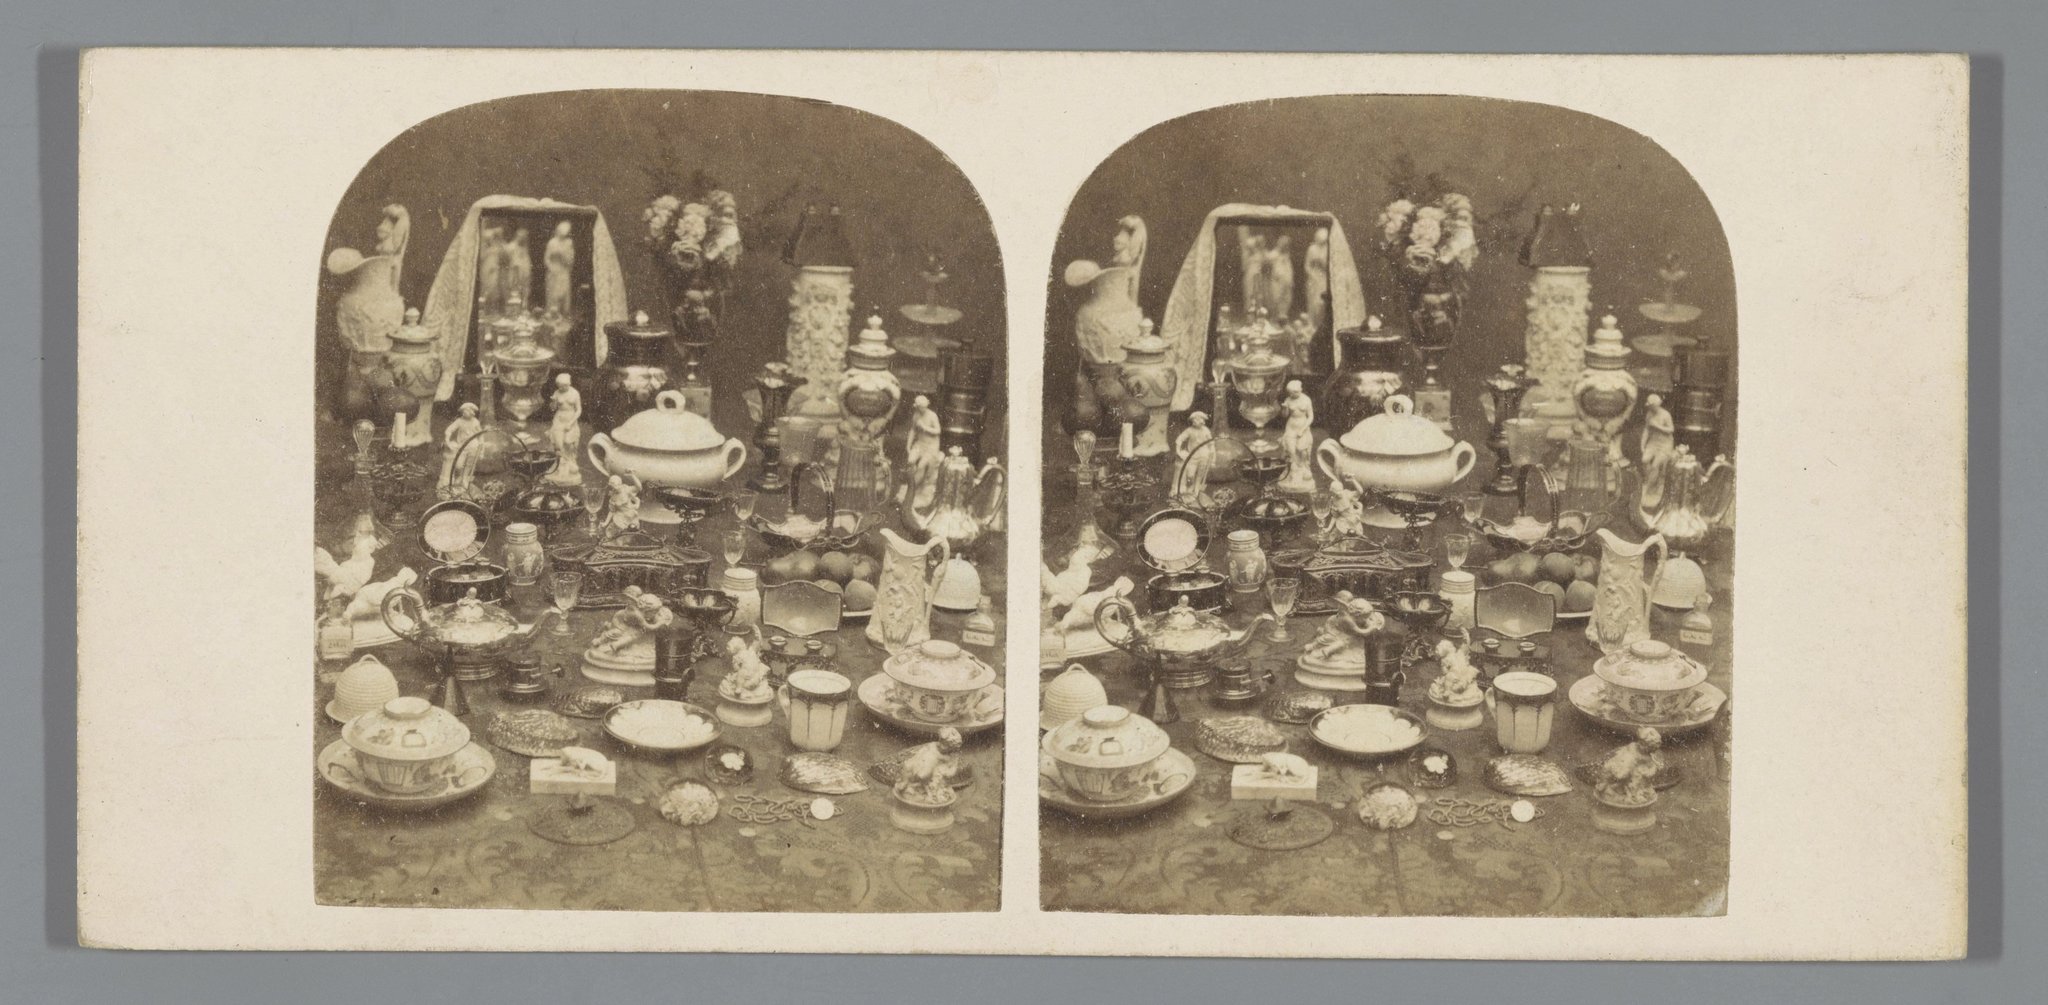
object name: stereograph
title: Stilleven met serviesgoed en sculpturen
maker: Anonymous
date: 1855-1870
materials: cardboard, photographic support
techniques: albumen print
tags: container of ceramics: jar, jug, pot, vase, still life of miscellaneous objects